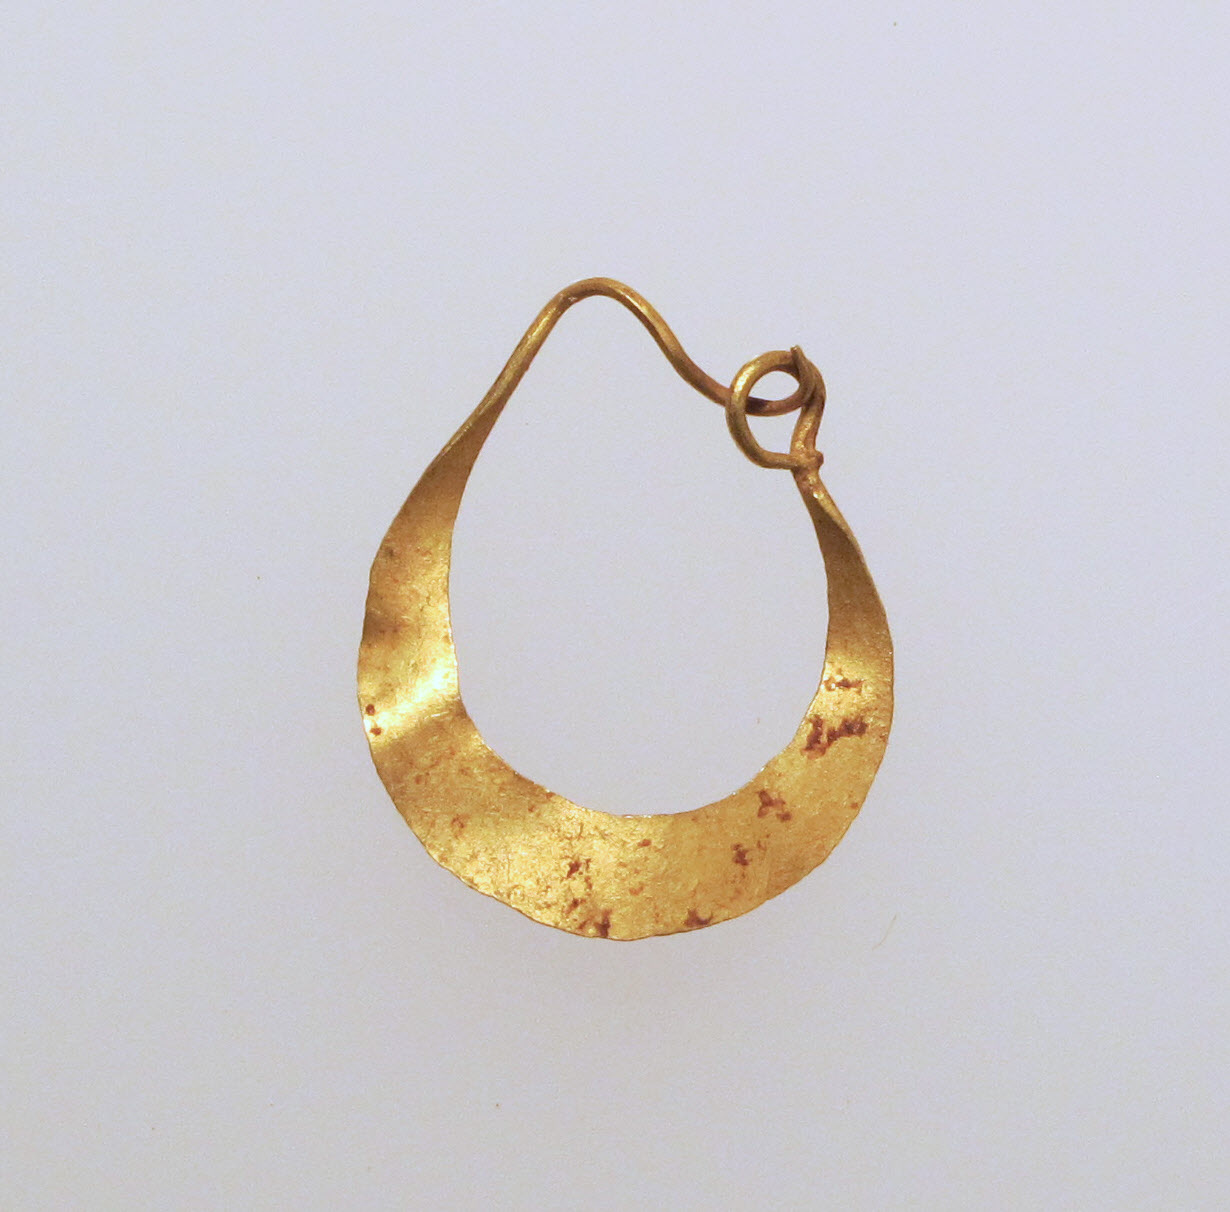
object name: earring, crescent shaped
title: Earring, crescent-shaped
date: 7000 BCE-330 CE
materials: gold